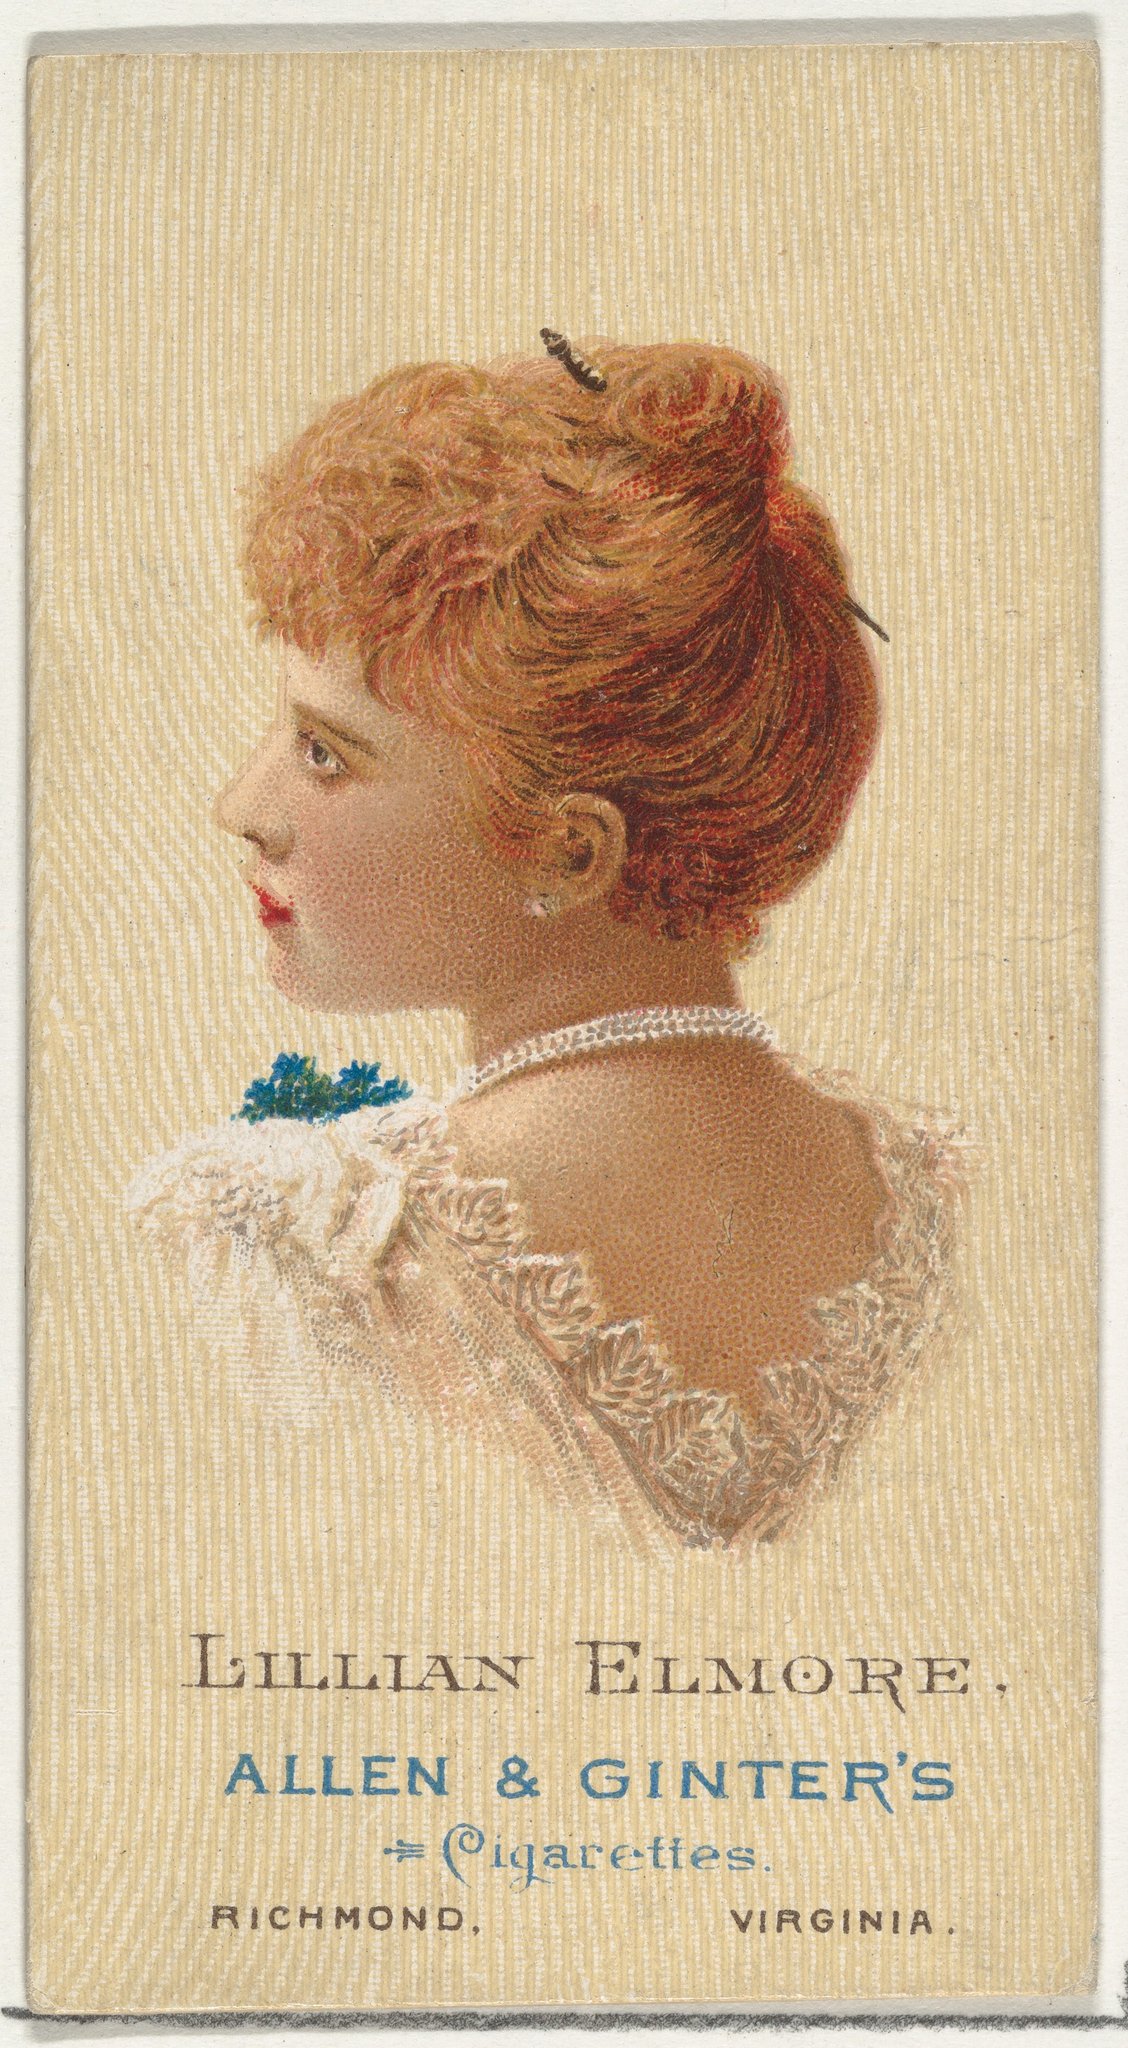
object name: print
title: Lillian Elmore, from World's Beauties, Series 2 (N27) for Allen & Ginter Cigarettes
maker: allen & ginter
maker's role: publisher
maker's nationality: american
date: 1888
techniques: color lithograph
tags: women